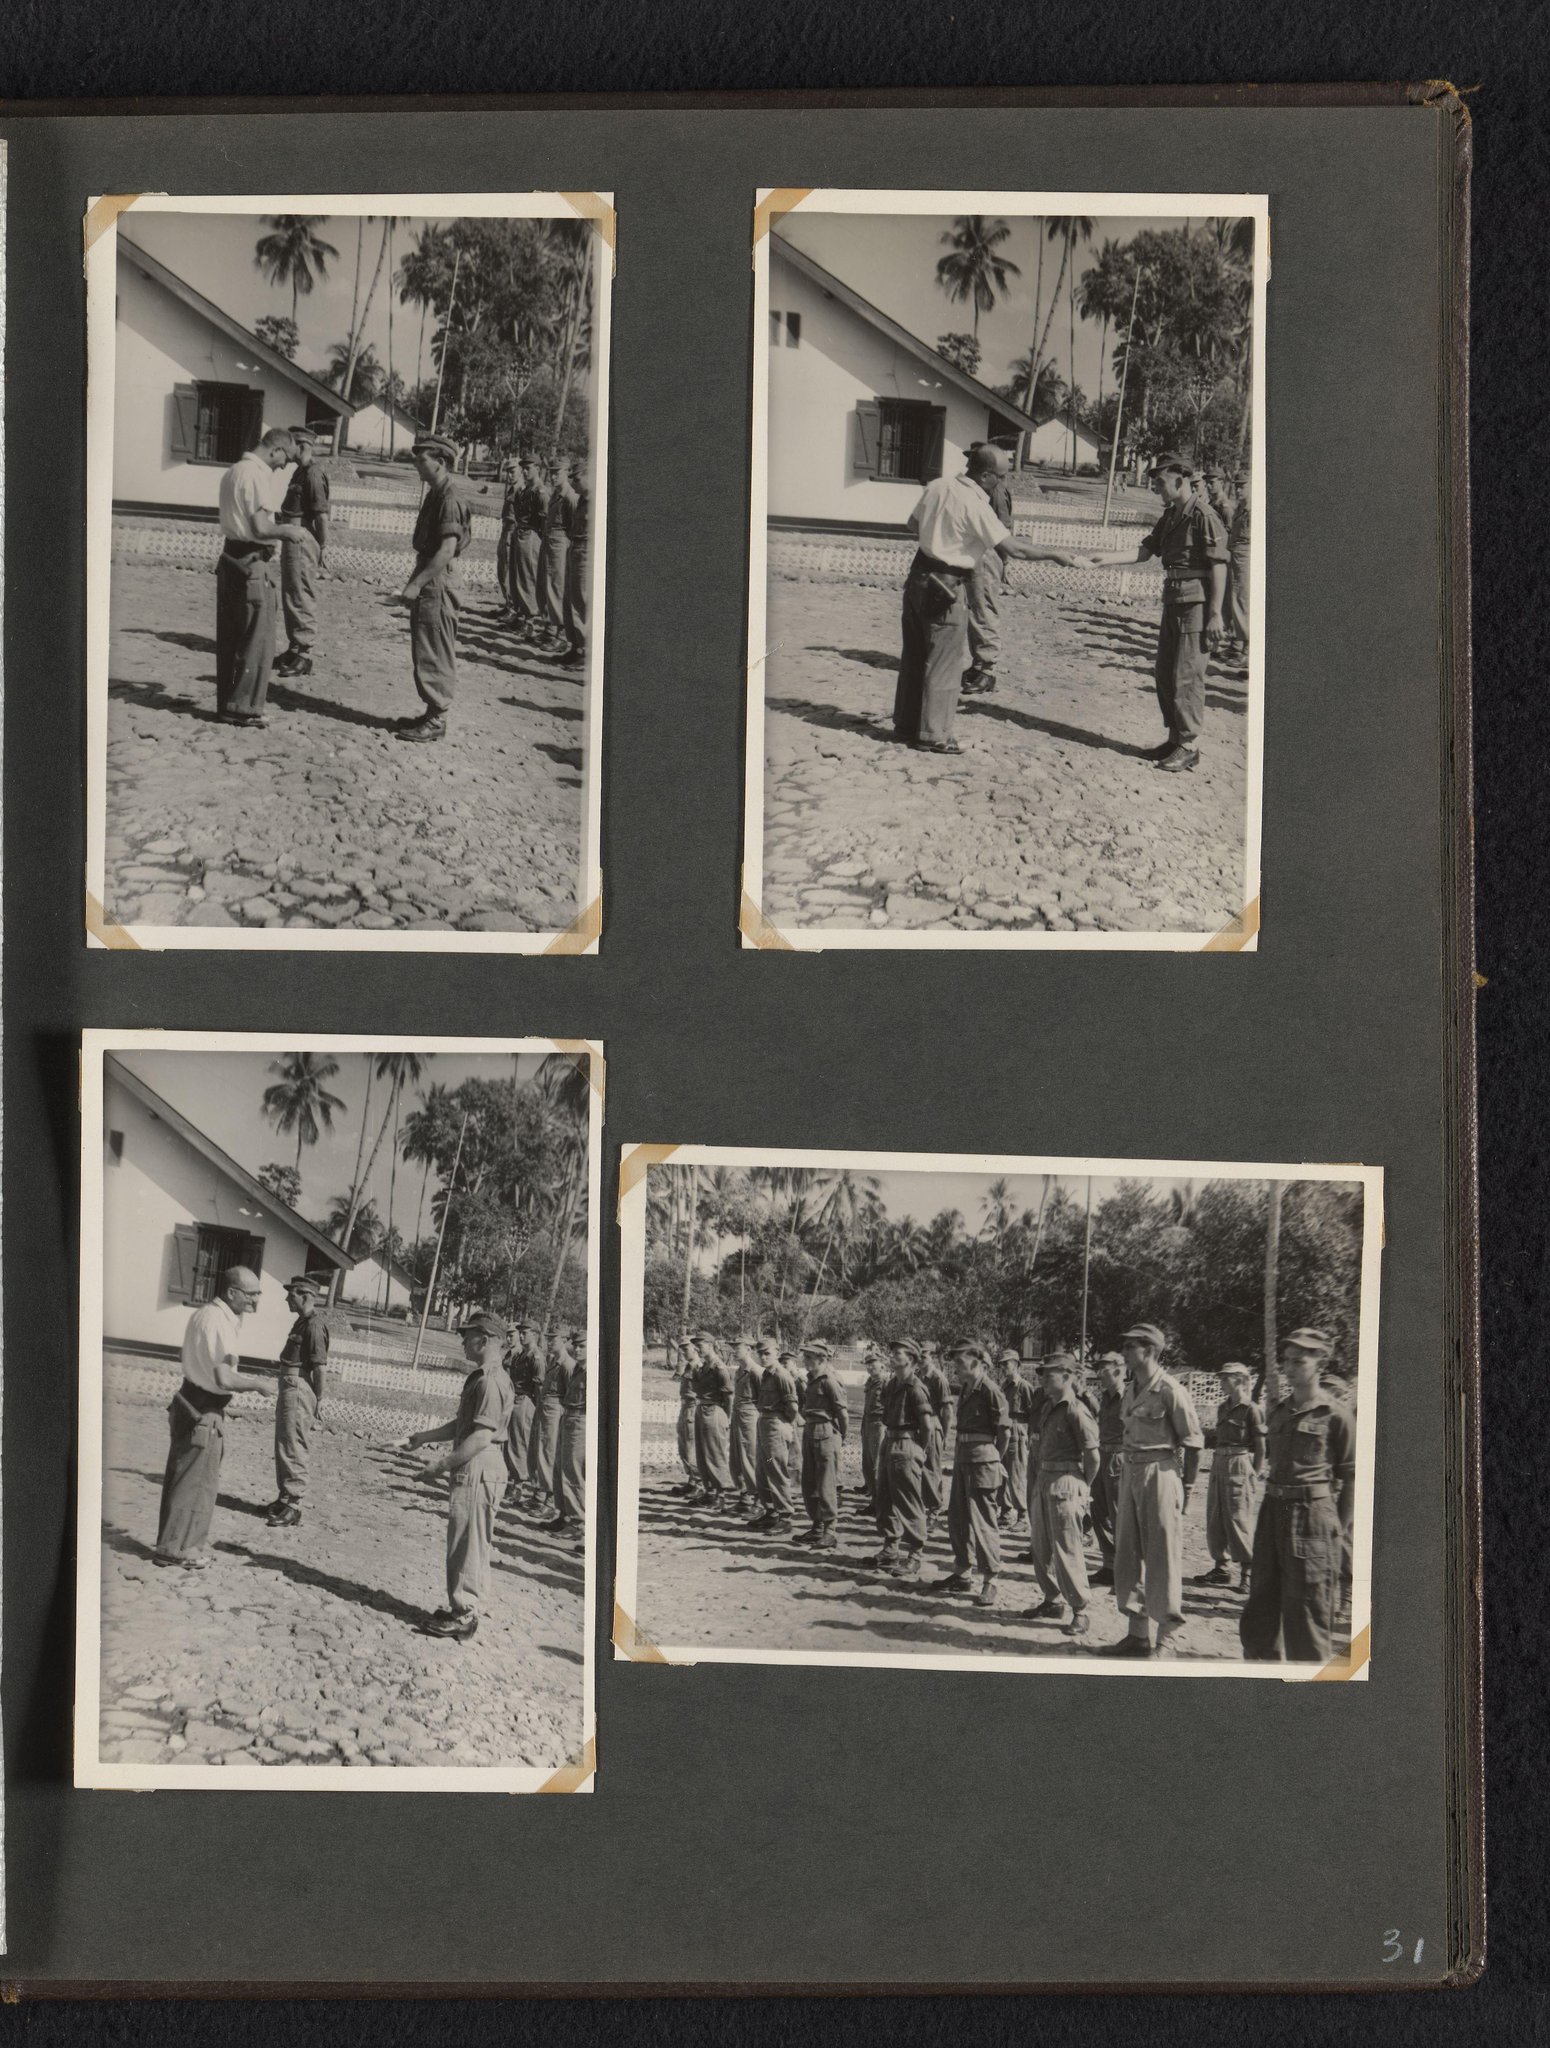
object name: album leaf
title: Nederlandse militairen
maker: Anonymous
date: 1907-1949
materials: cardboard, photographic support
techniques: gelatin silver print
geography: dutch east indies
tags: the company, the unit, the troop ~ military service, historical persons, shelter ~ military service, dutch east indies, the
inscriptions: inscription: ‘Tjikalongkoelon / Uitreiking van de sigaretten... voor de verdedigers van K...Pajoeng Troep. aange... / Juli 1949’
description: Albumblad met vier foto's van de uitreiking van een beloning aan Nederlandse militairen in het kampement in Tjikalonkoelon (Cikalong-kulon) voor hun inzet bij een militaire actie. Onderdeel van het fotoalbum 'Mijn jaren in Indië' met foto's over de militaire acties in Nederlands-Indië.